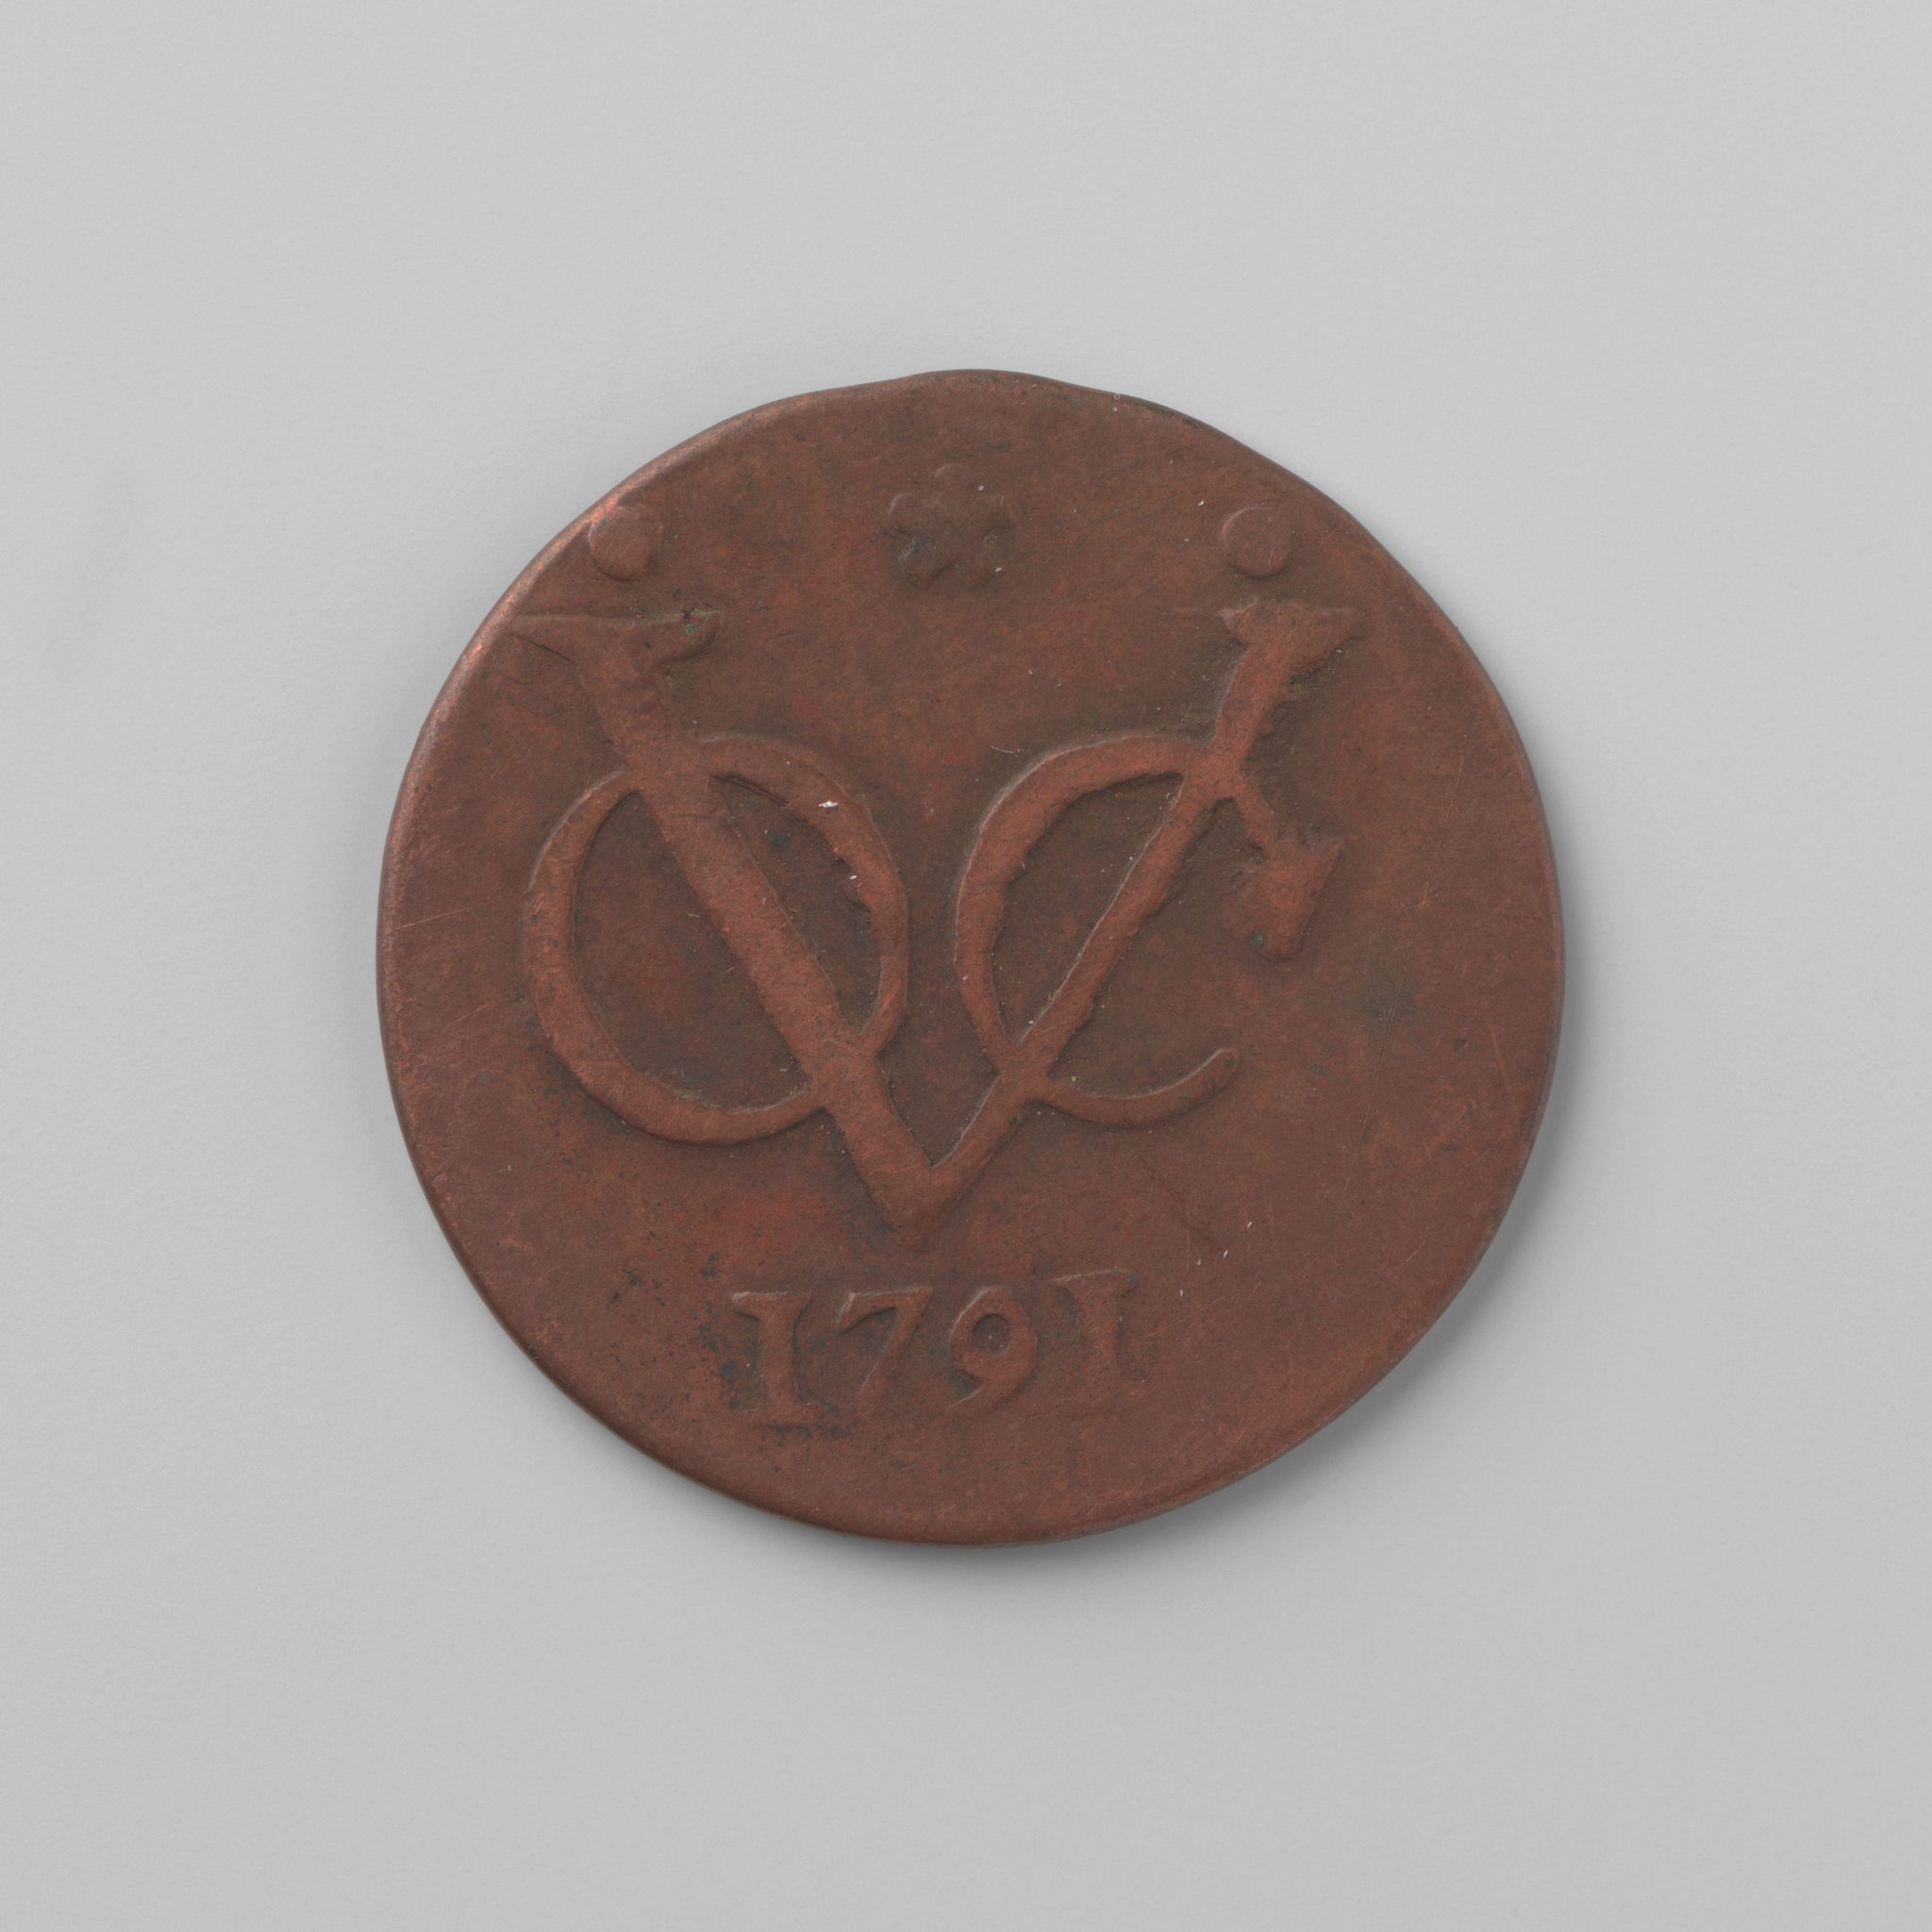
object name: coin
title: VOC, duit Westfriesland,1791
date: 1791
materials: copper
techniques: striking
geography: hoorn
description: Koperen munt. Voorzijde: gekroond wapenschild van Westfriesland. Keerzijde: monogram van de VOC, waarboven muntteken en waaronder jaartal. Gladde rand.